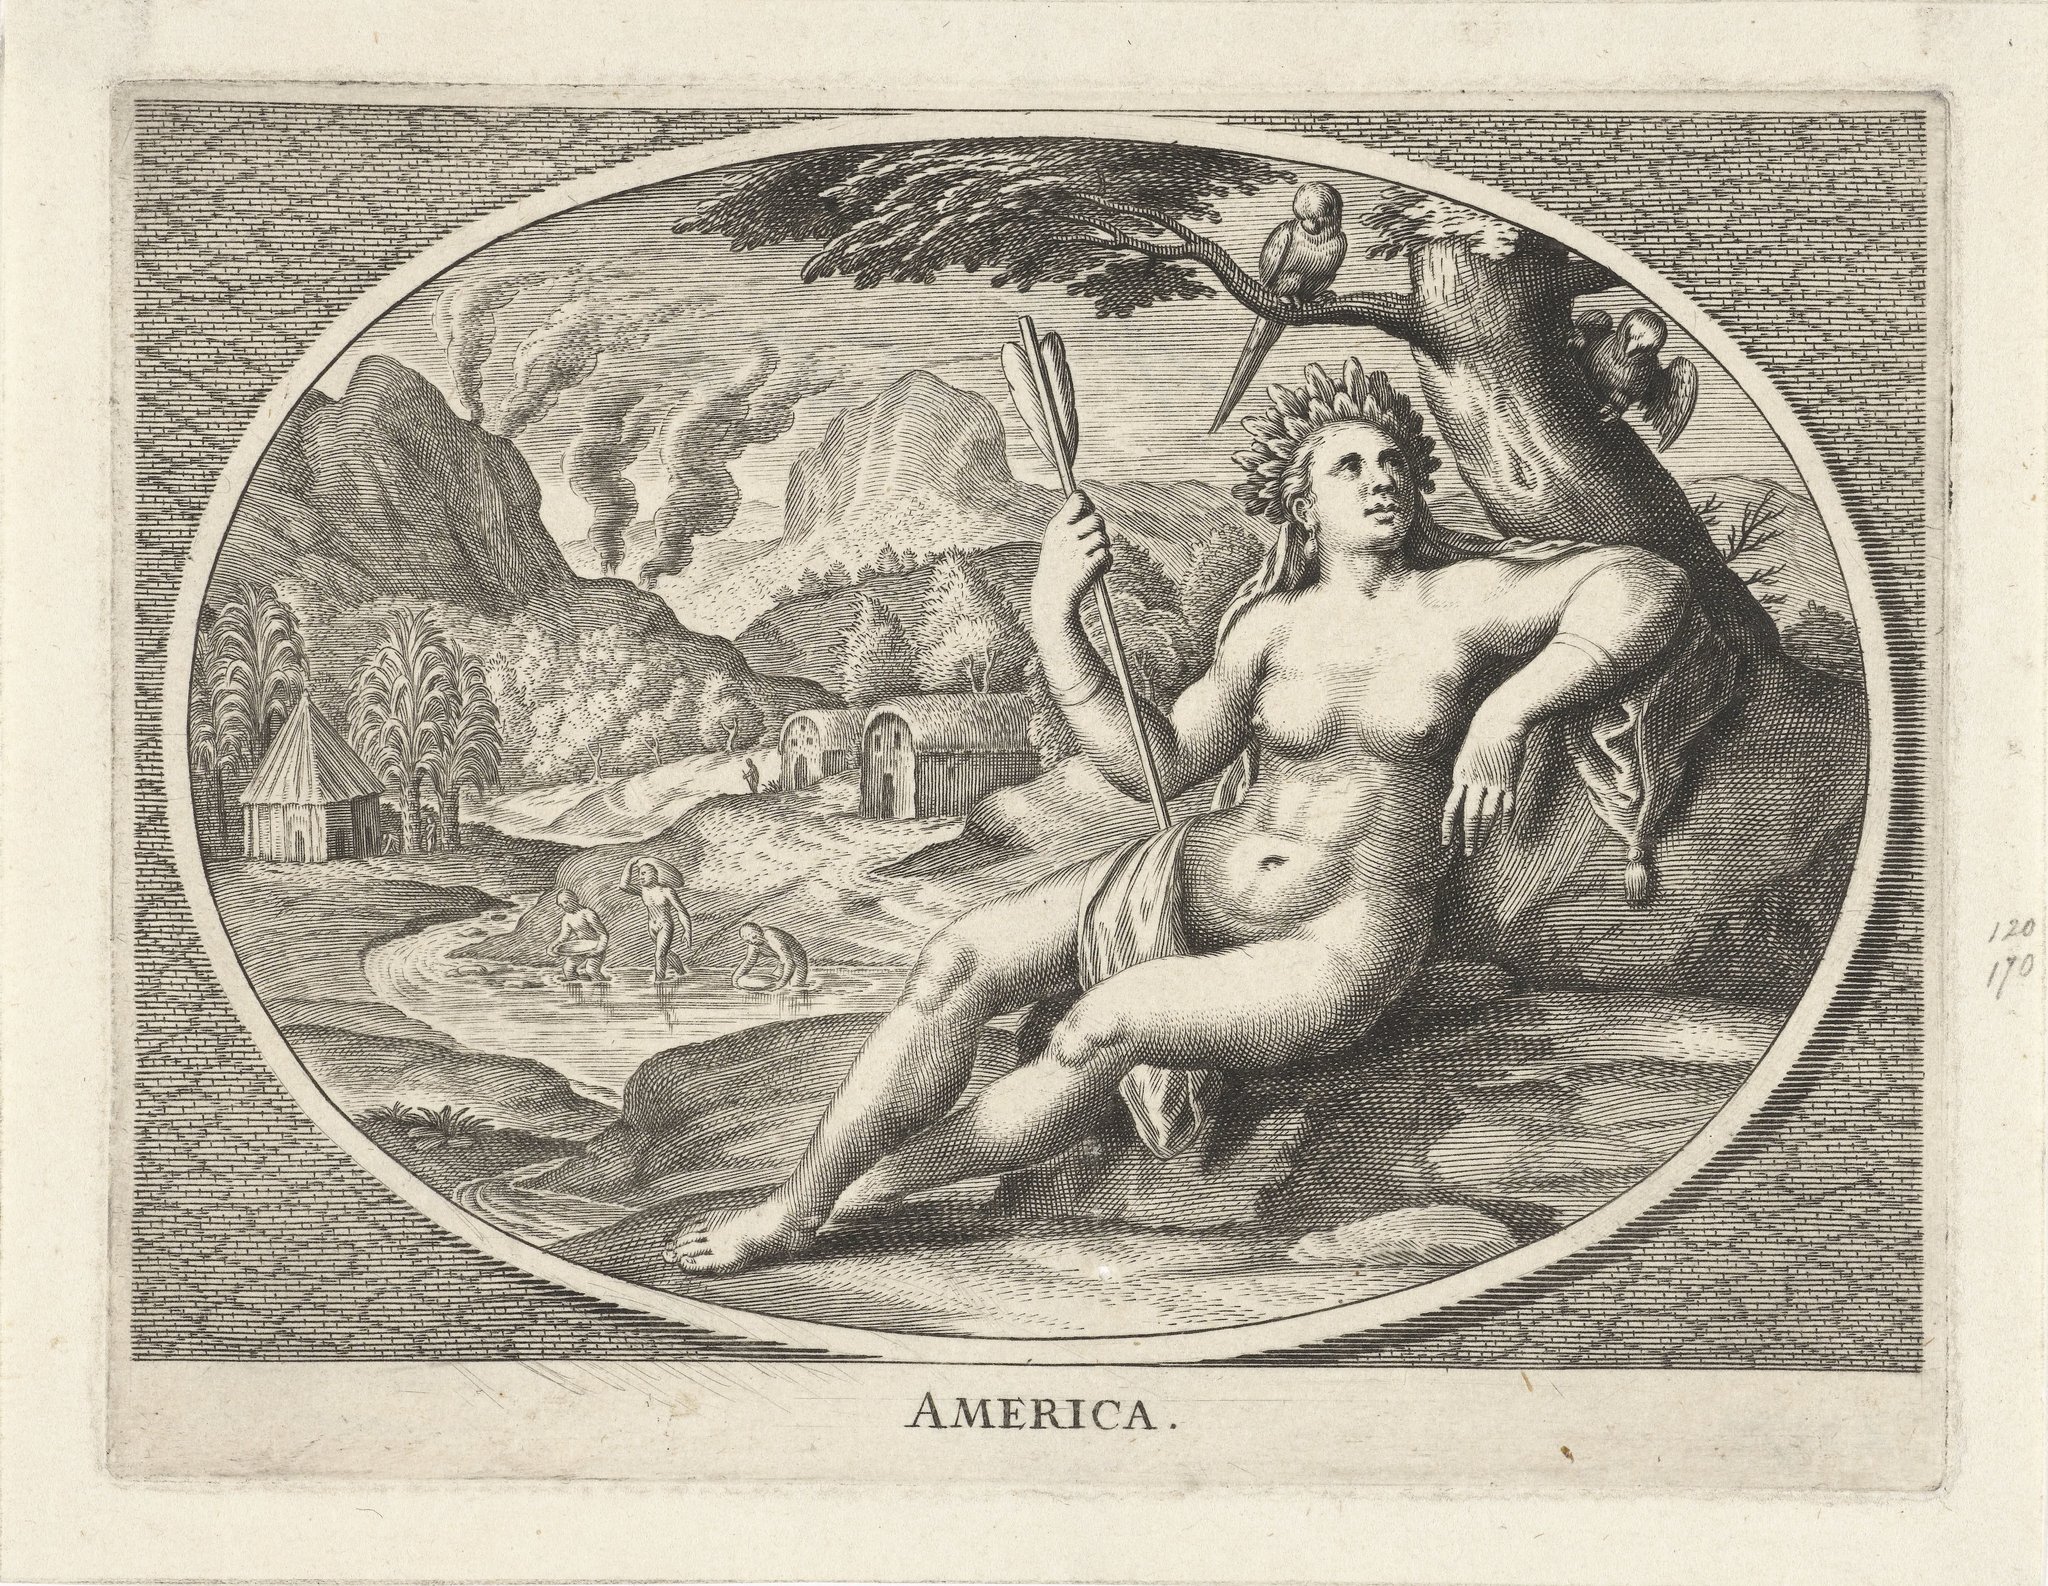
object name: print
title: America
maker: cornelis van dalen (ii)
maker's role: draughtsman, print maker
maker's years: 1638-1664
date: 1648-1664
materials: paper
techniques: engraving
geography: amsterdam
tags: america represented allegorically; 'america' (ripa)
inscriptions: collector's mark: Lugt 2228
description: Prent mogelijk naar ontwerp van Dirck Barendsz., zie aantekening verso RP-P-1886-A-10408.